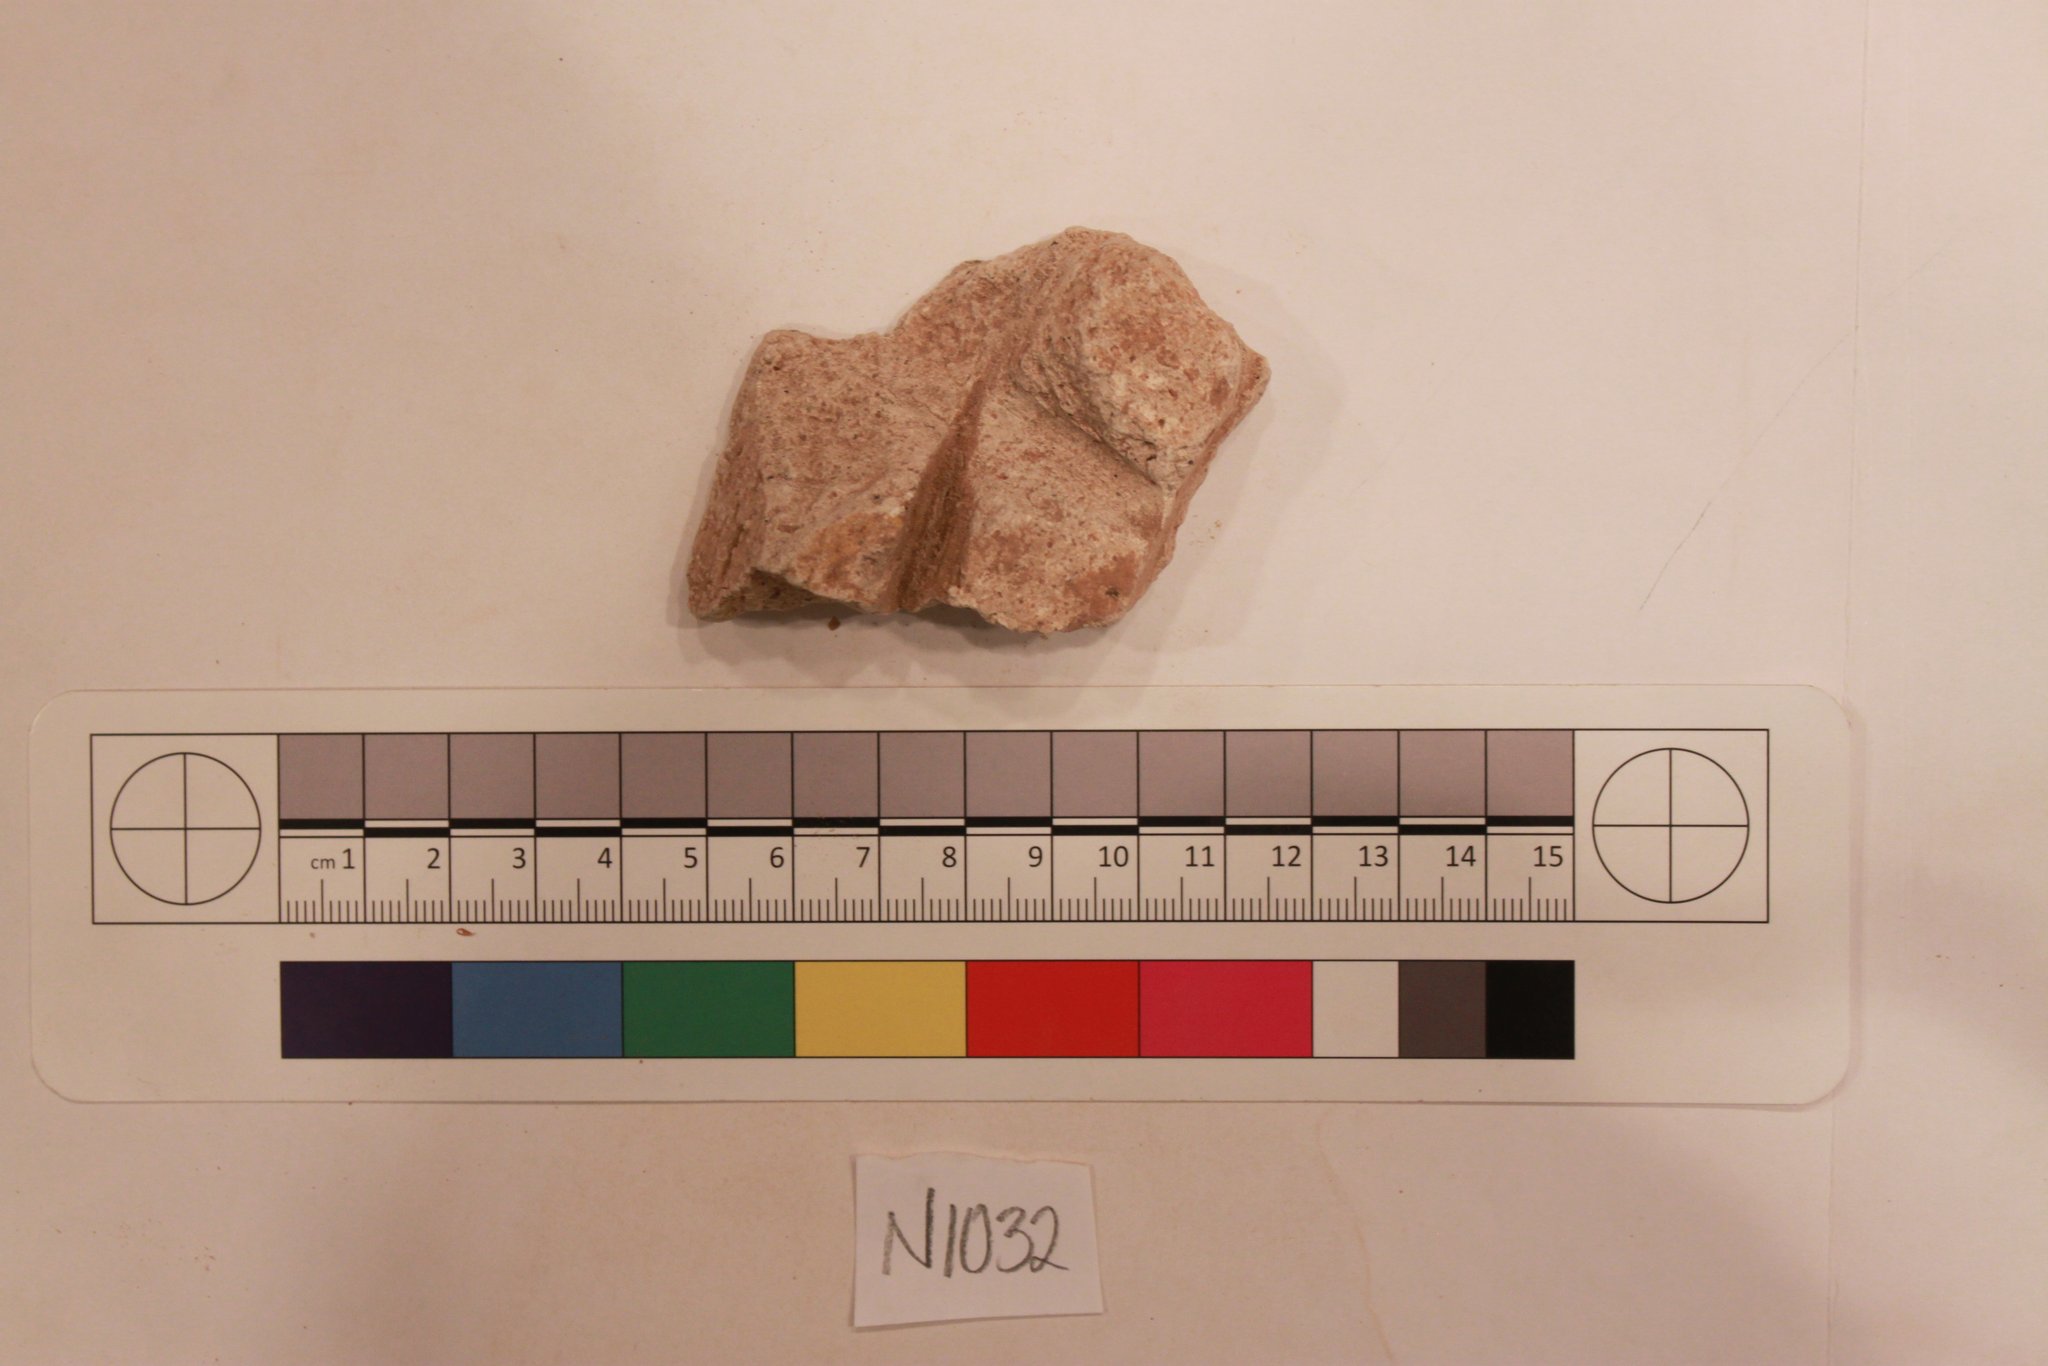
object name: fragment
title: Stucco Fragment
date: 701-1200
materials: plaster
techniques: carving, painting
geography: iran